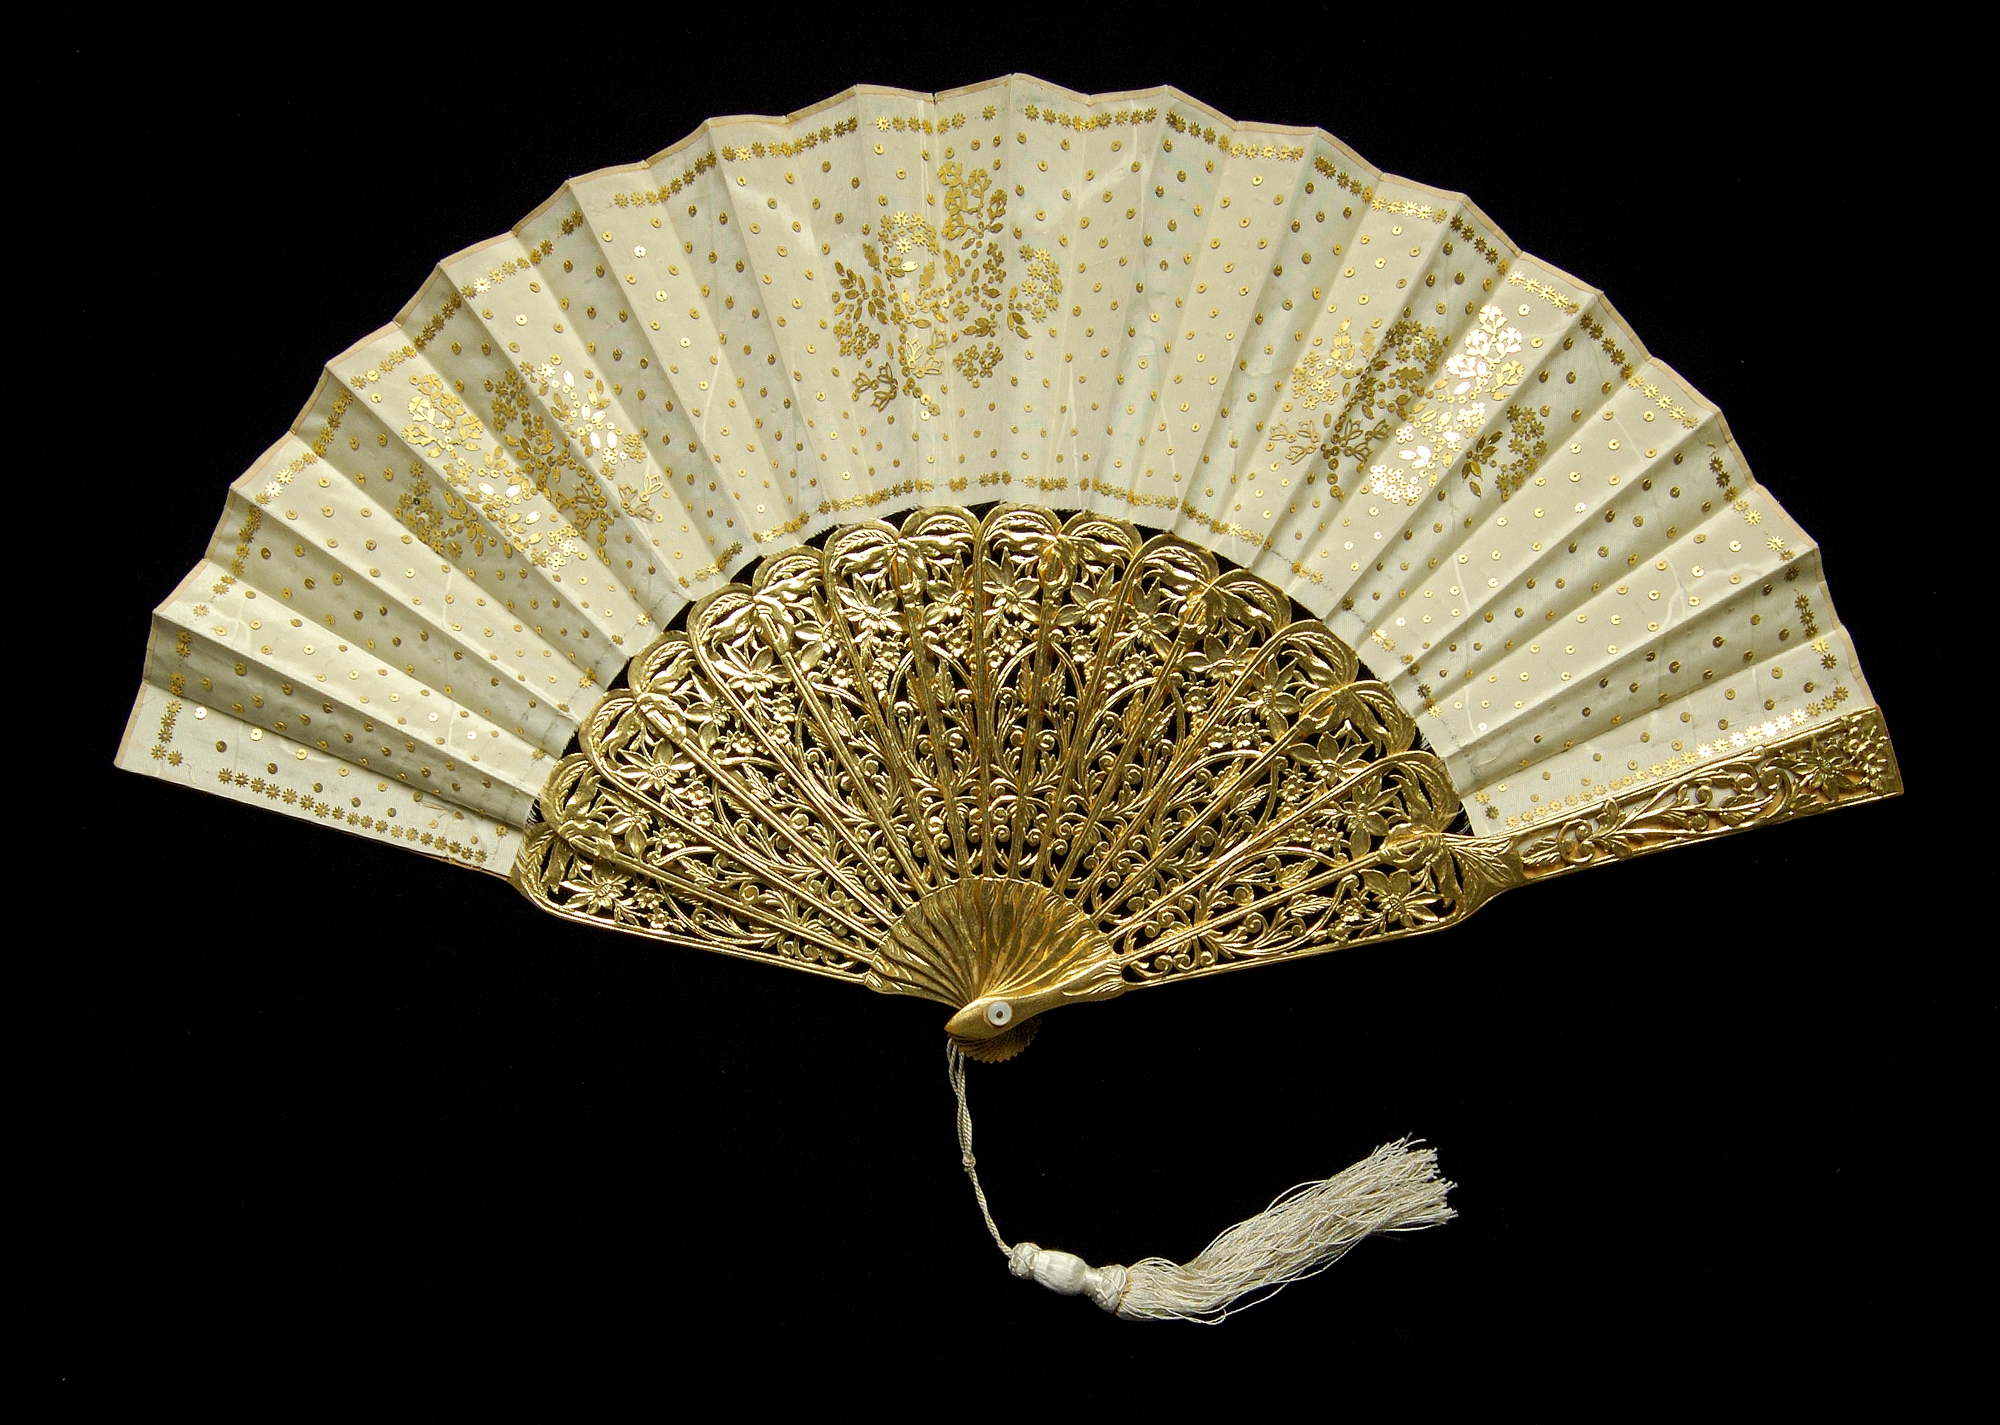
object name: fan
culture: french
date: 1860-1869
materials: mother of pearl, silk, wood